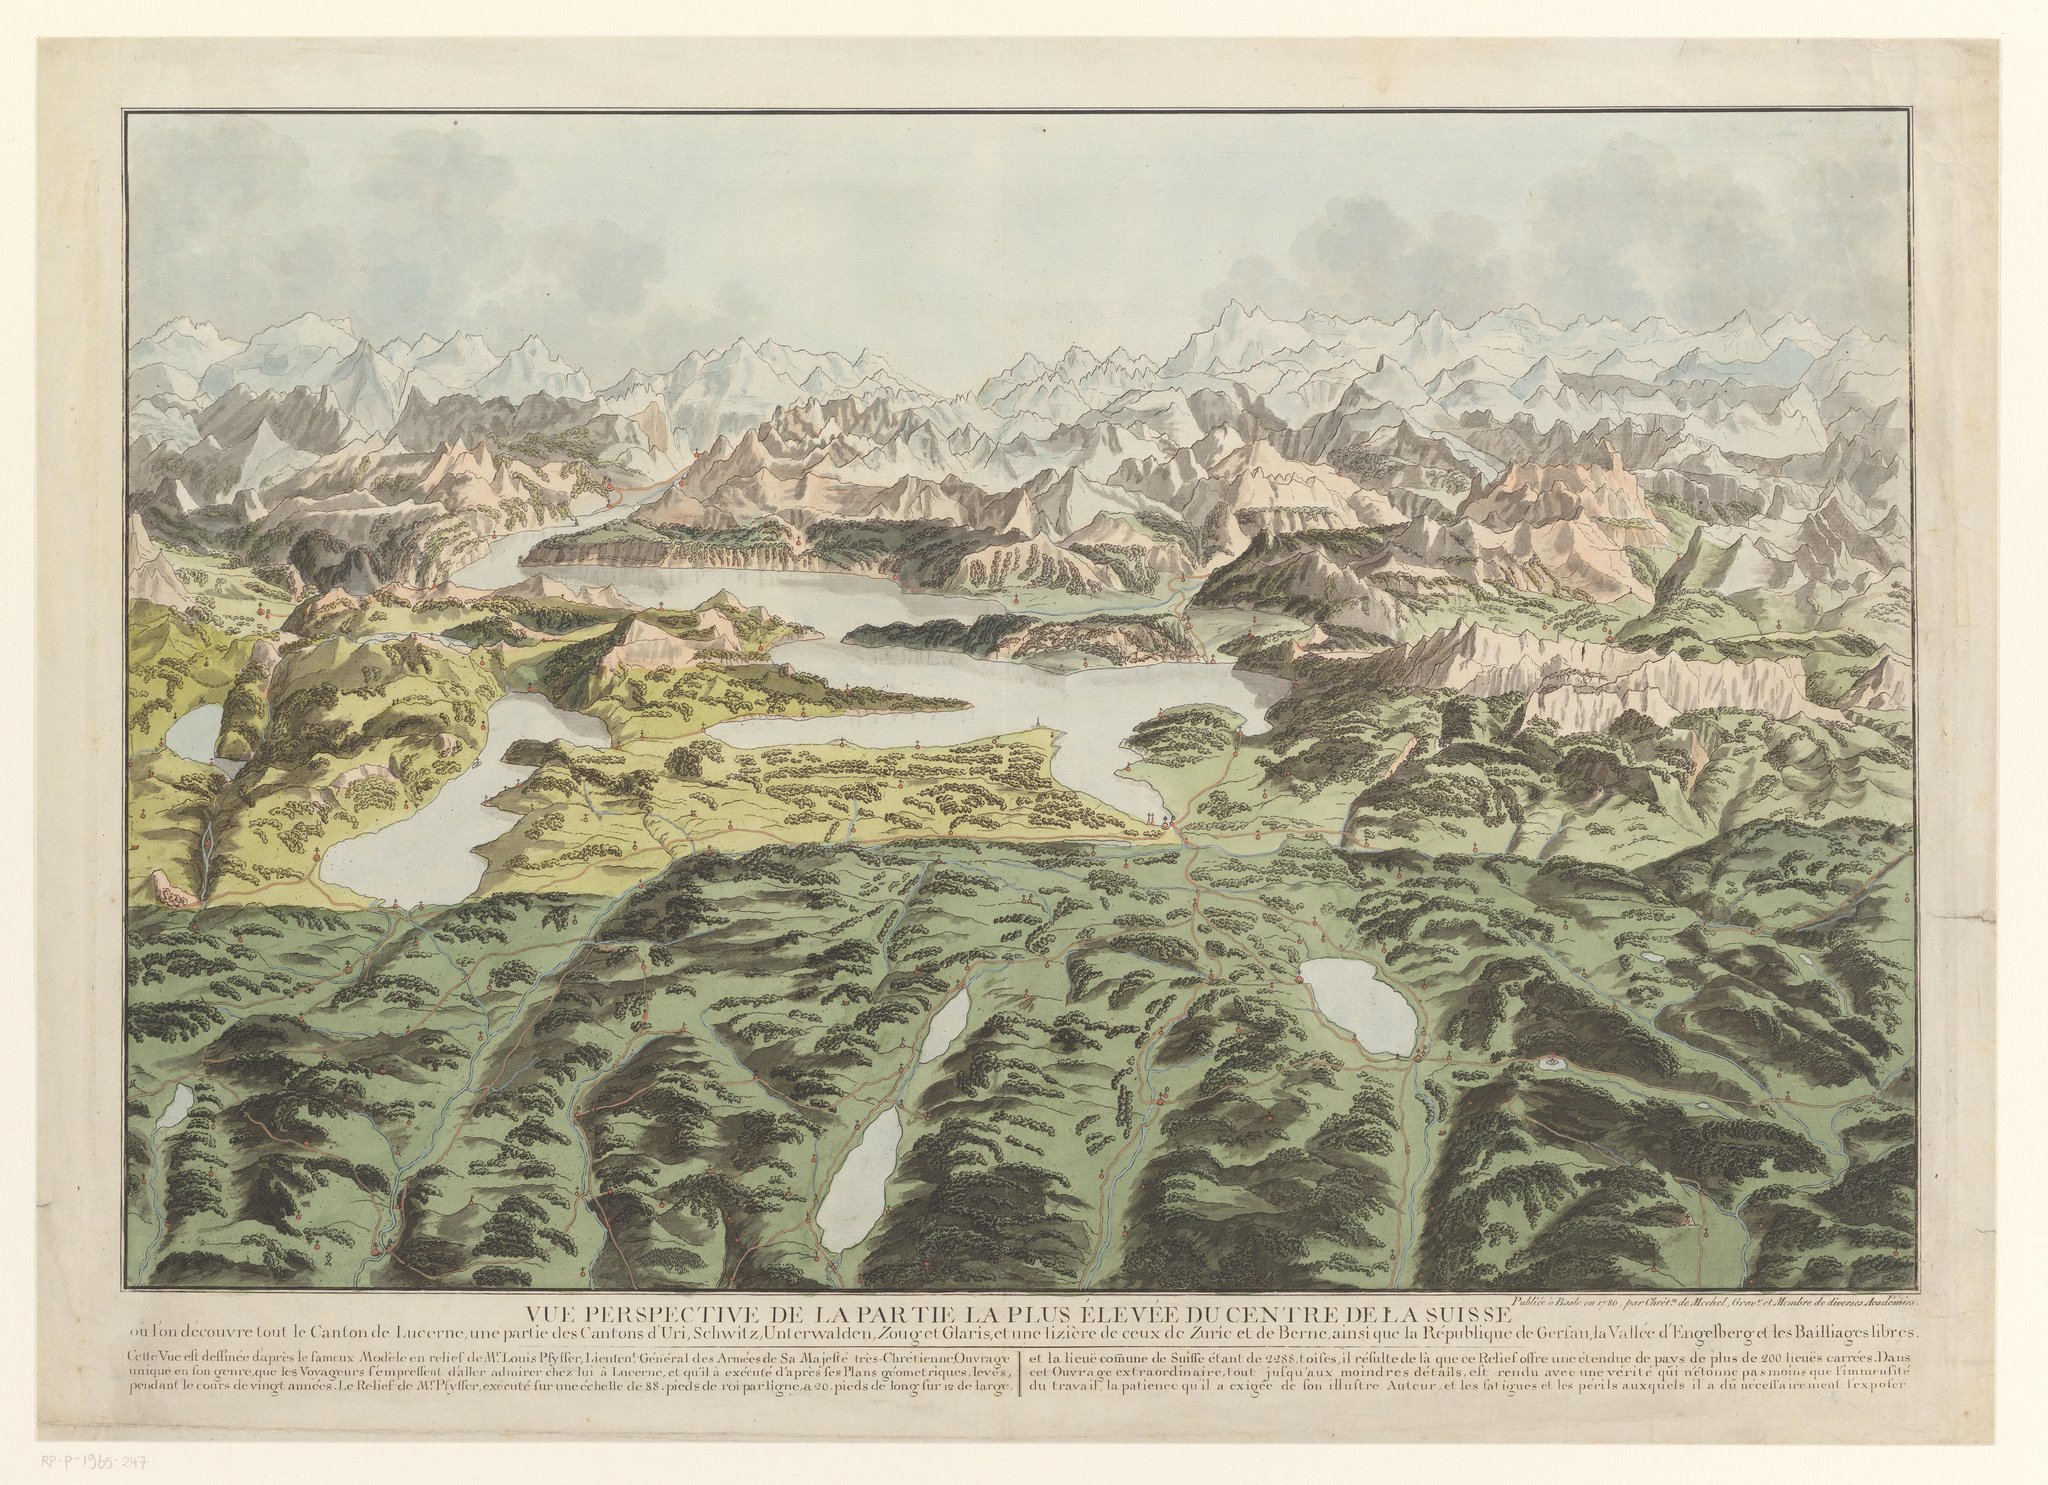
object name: print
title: Kaart van meerdere kantons en regionen in Zwitserland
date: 1786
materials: paper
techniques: etching, hand coloring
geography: basel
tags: maps of separate countries or regions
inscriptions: collector's mark: Lugt 2760, collector's mark: Lugt 2228